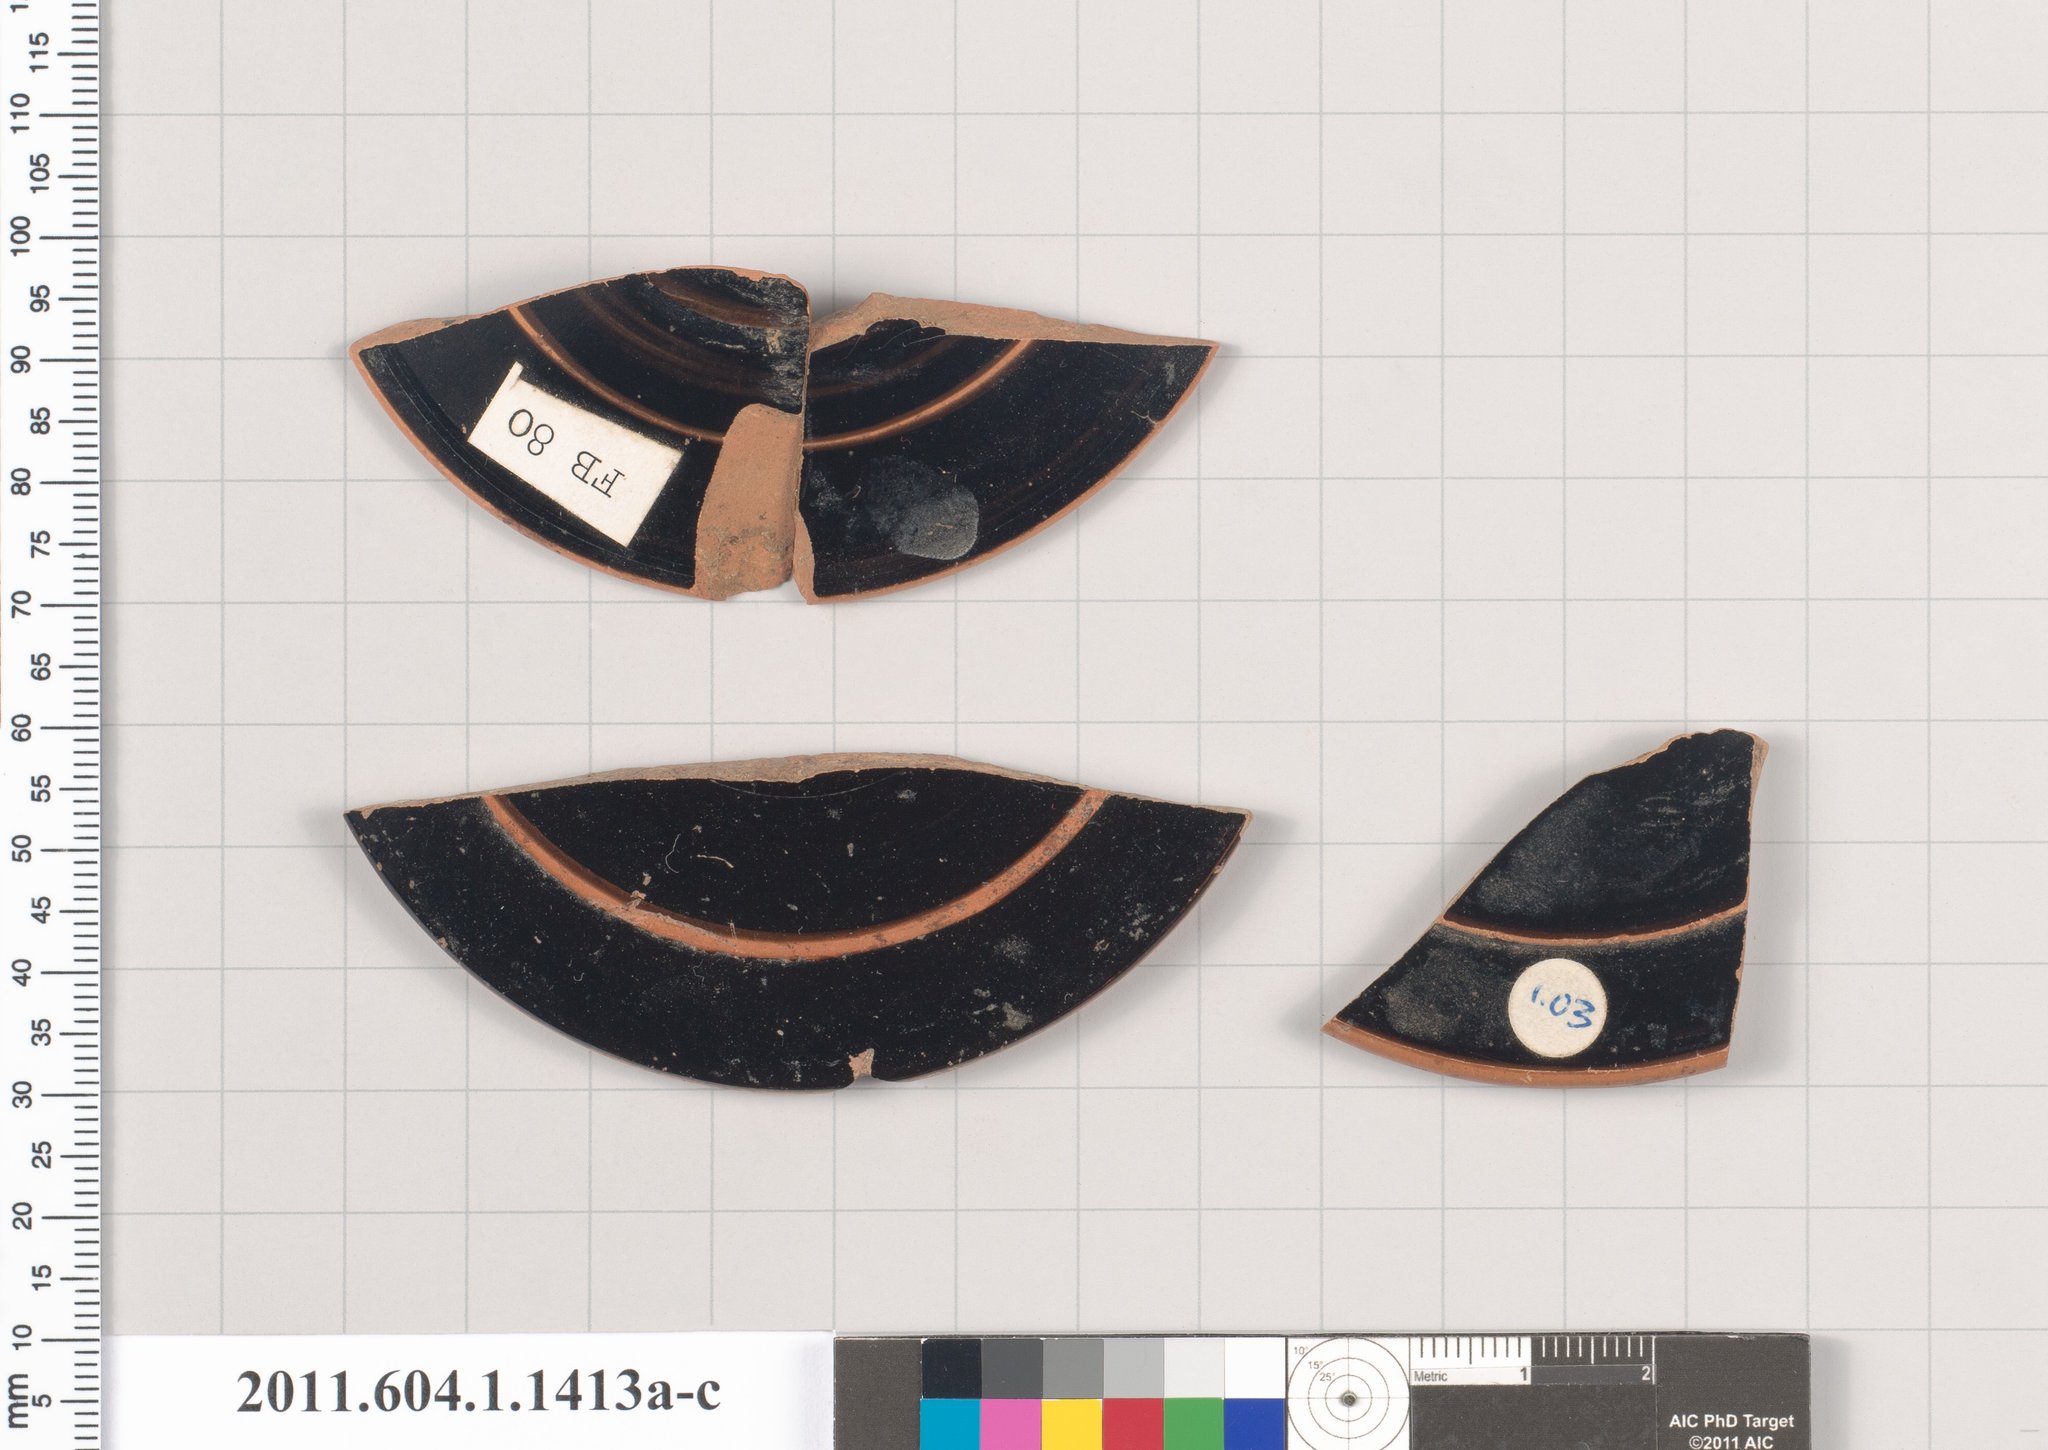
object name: kylix fragment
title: Terracotta fragments of kylikes (drinking cups)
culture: greek, attic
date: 500-401 BCE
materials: terracotta